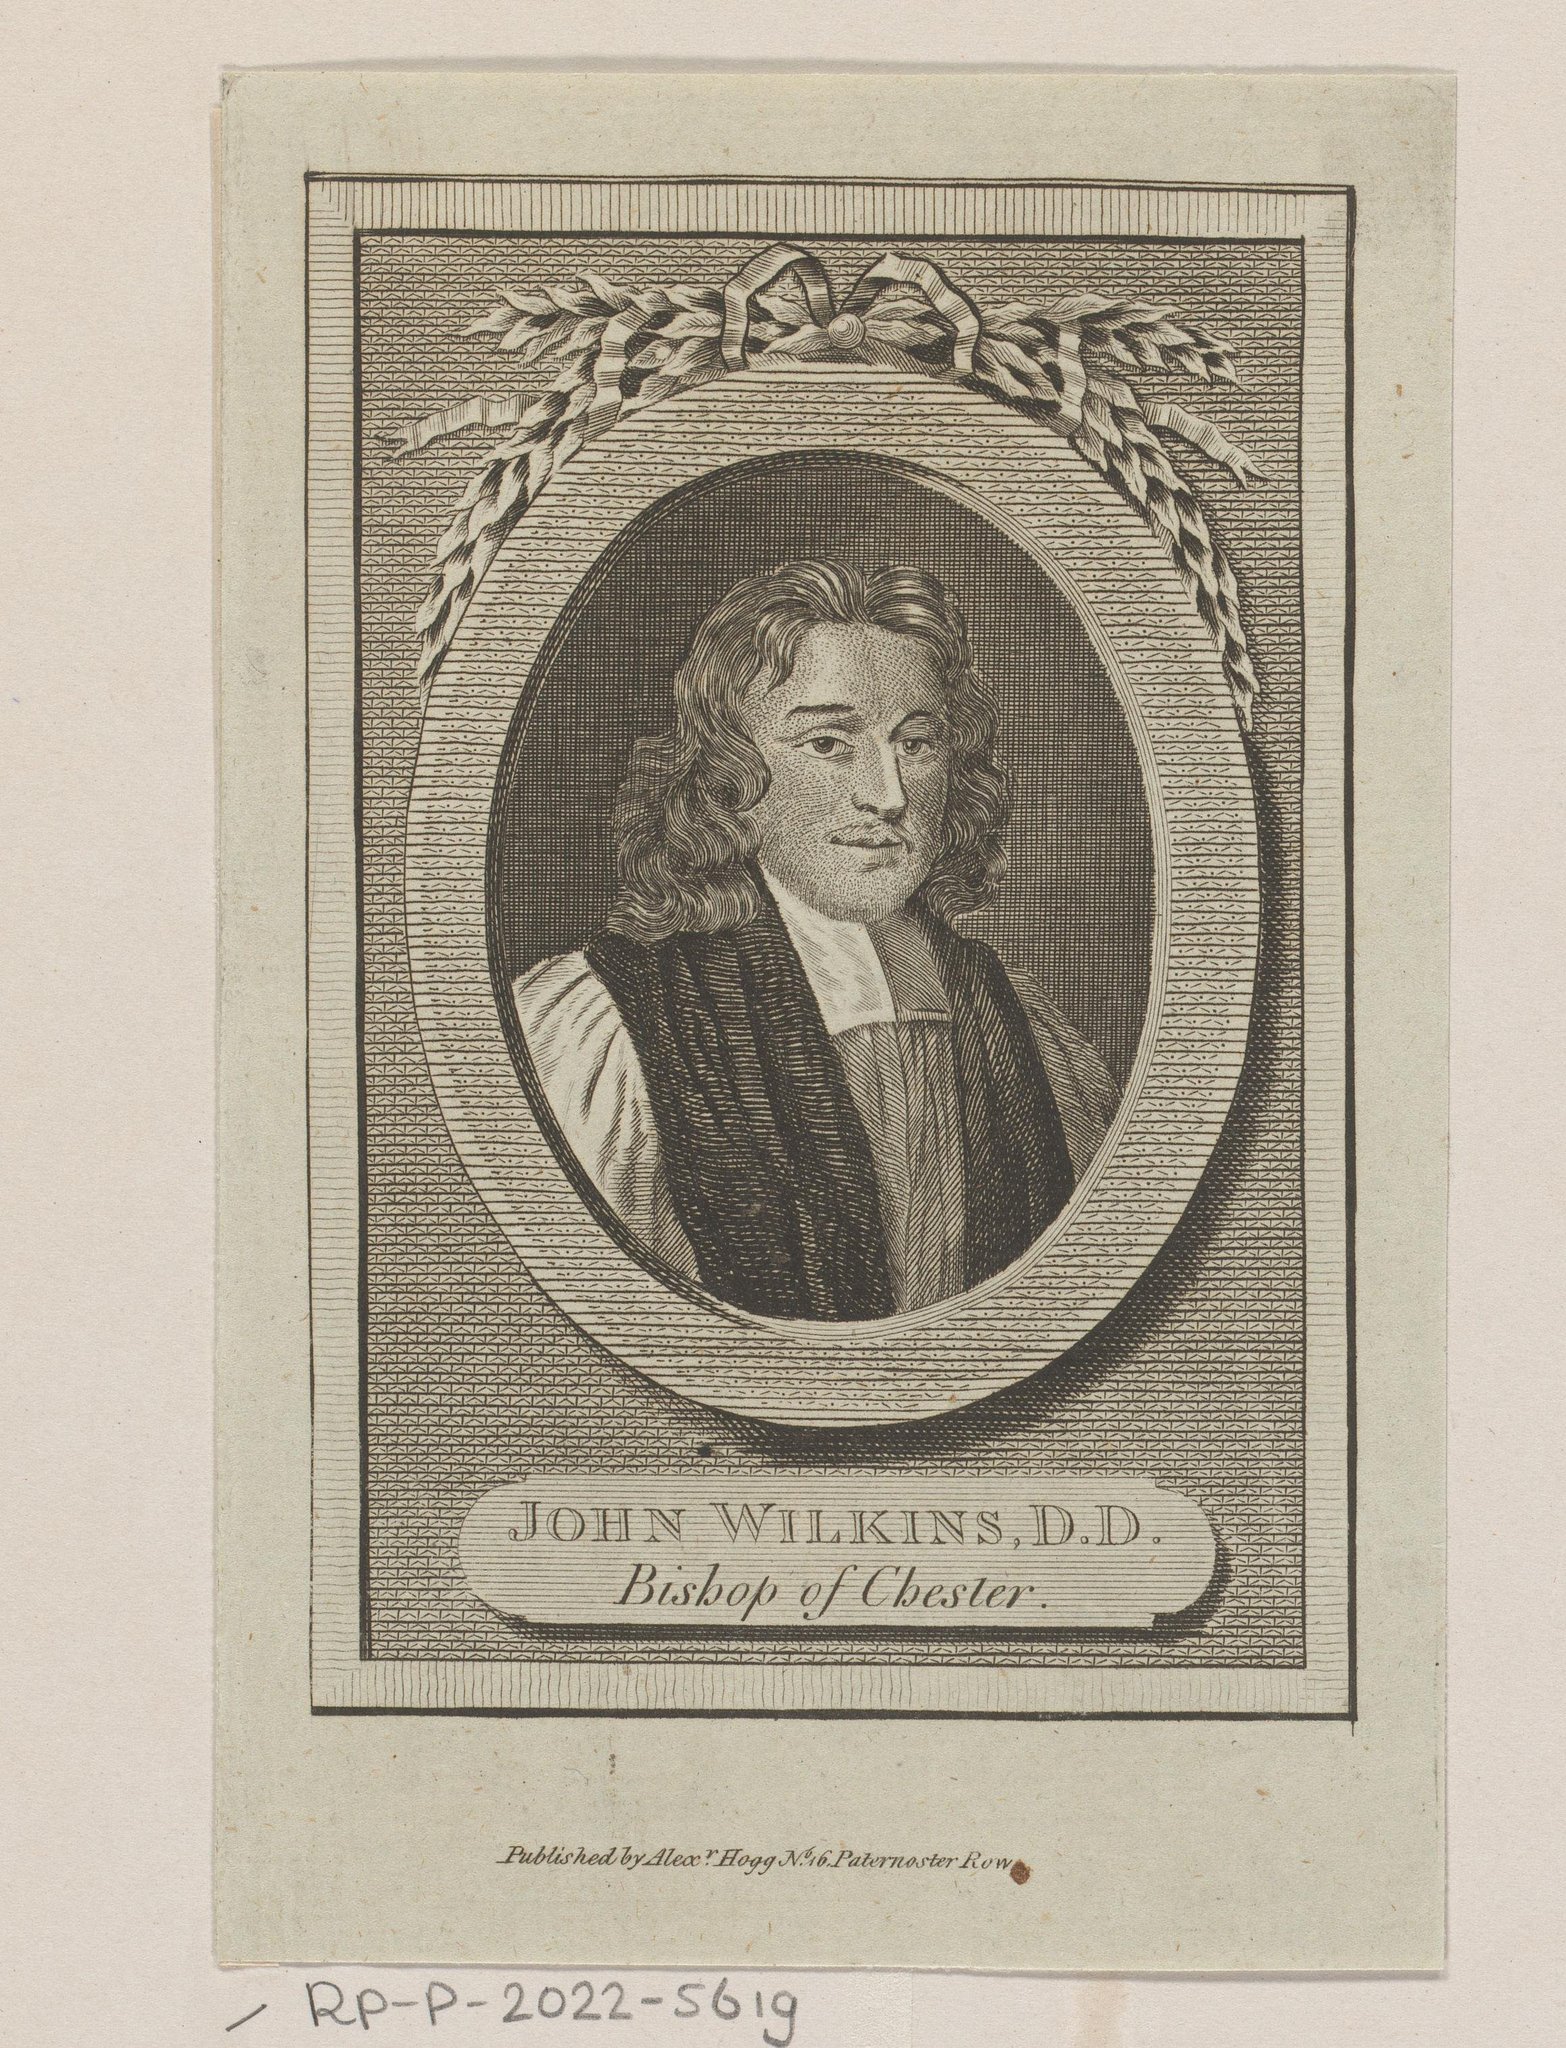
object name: print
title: Portret van John Wilkins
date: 1788-1824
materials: paper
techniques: engraving, etching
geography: london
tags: historical persons